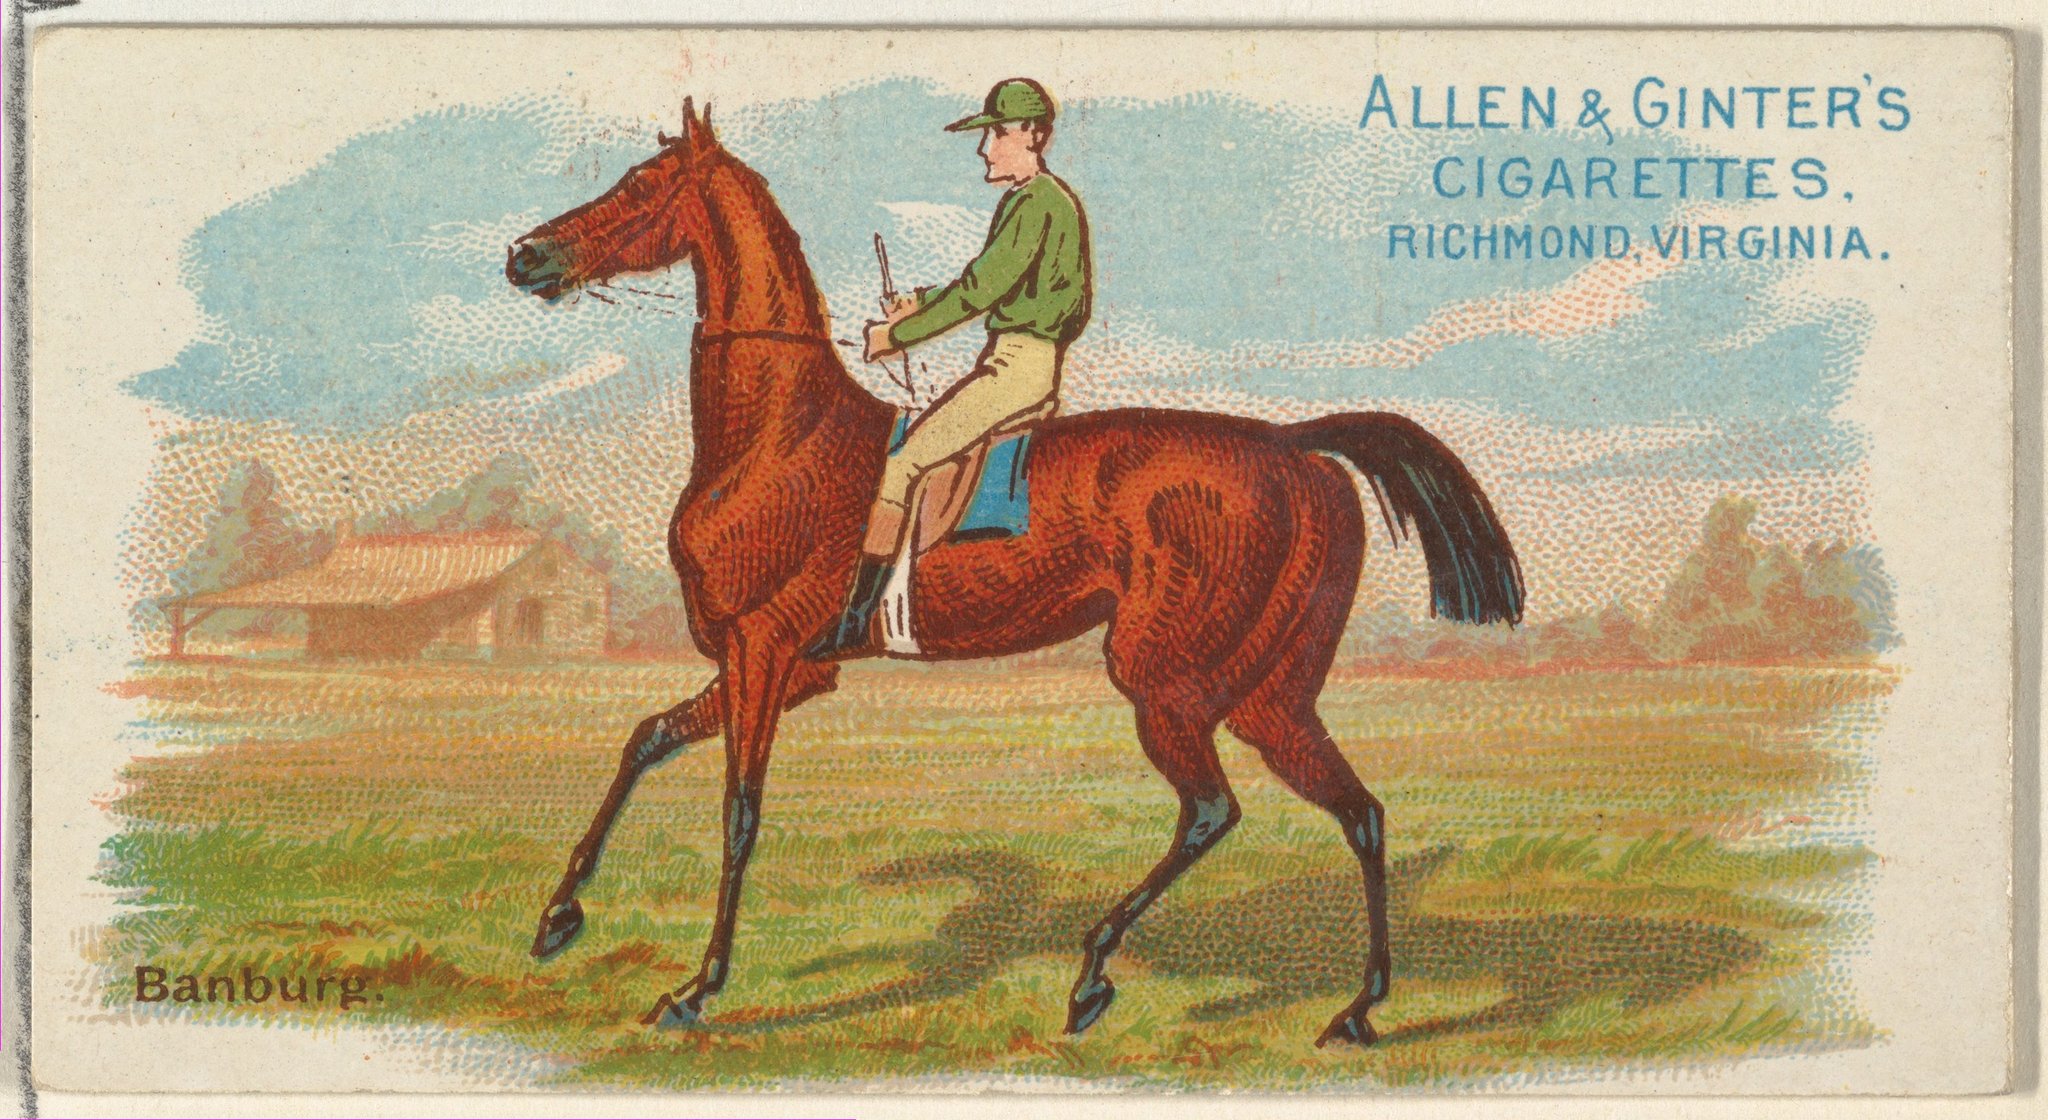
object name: print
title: Banburg, from The World's Racers series (N32) for Allen & Ginter Cigarettes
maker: allen & ginter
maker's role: publisher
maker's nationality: american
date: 1888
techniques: color lithograph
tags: men,horses,jockeys